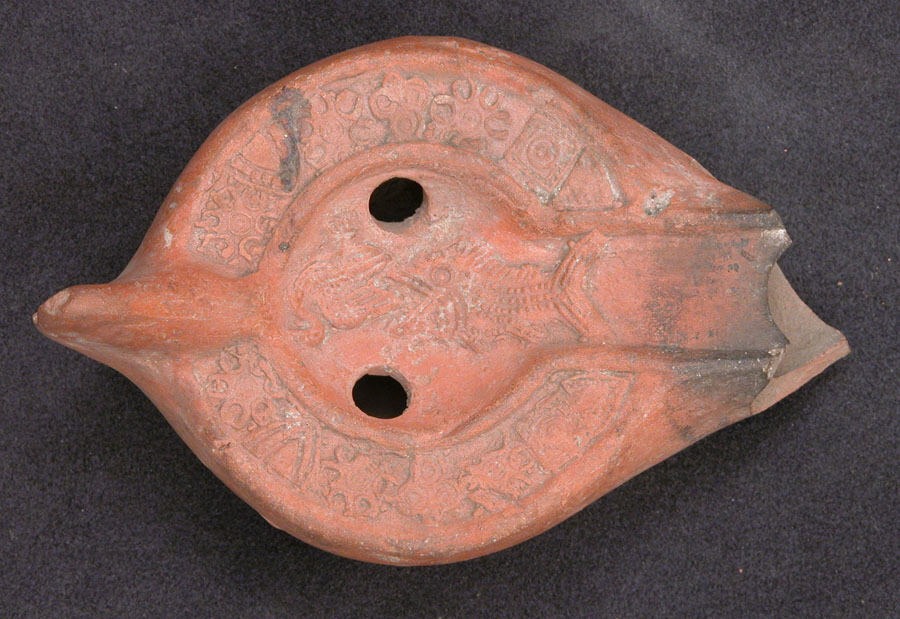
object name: lamp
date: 401-600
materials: earthenware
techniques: molding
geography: egypt